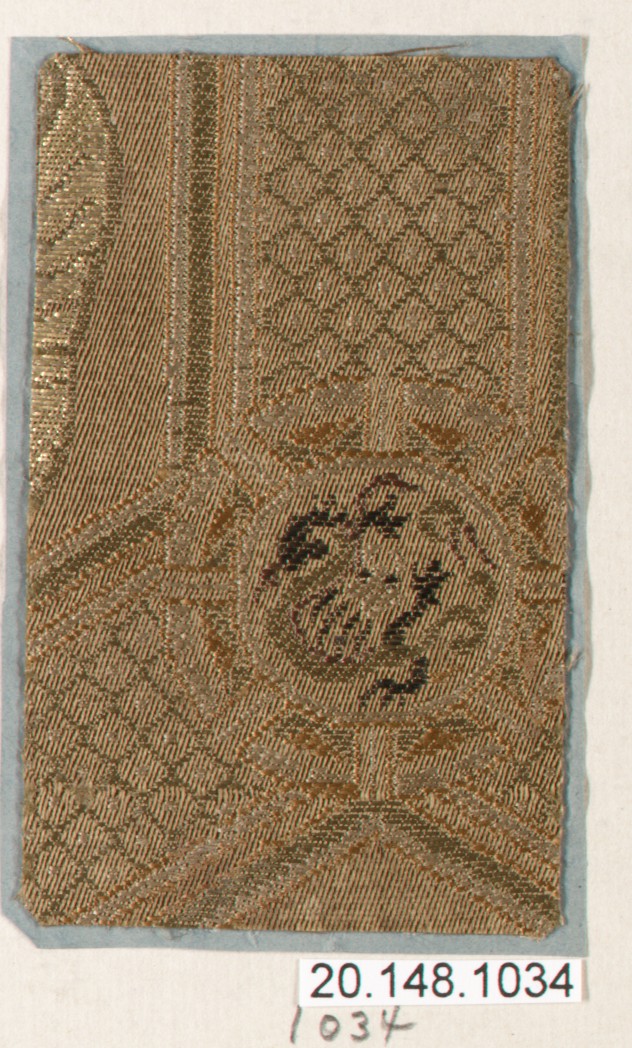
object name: piece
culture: japanese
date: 1701-1800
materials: silk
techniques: compound weave